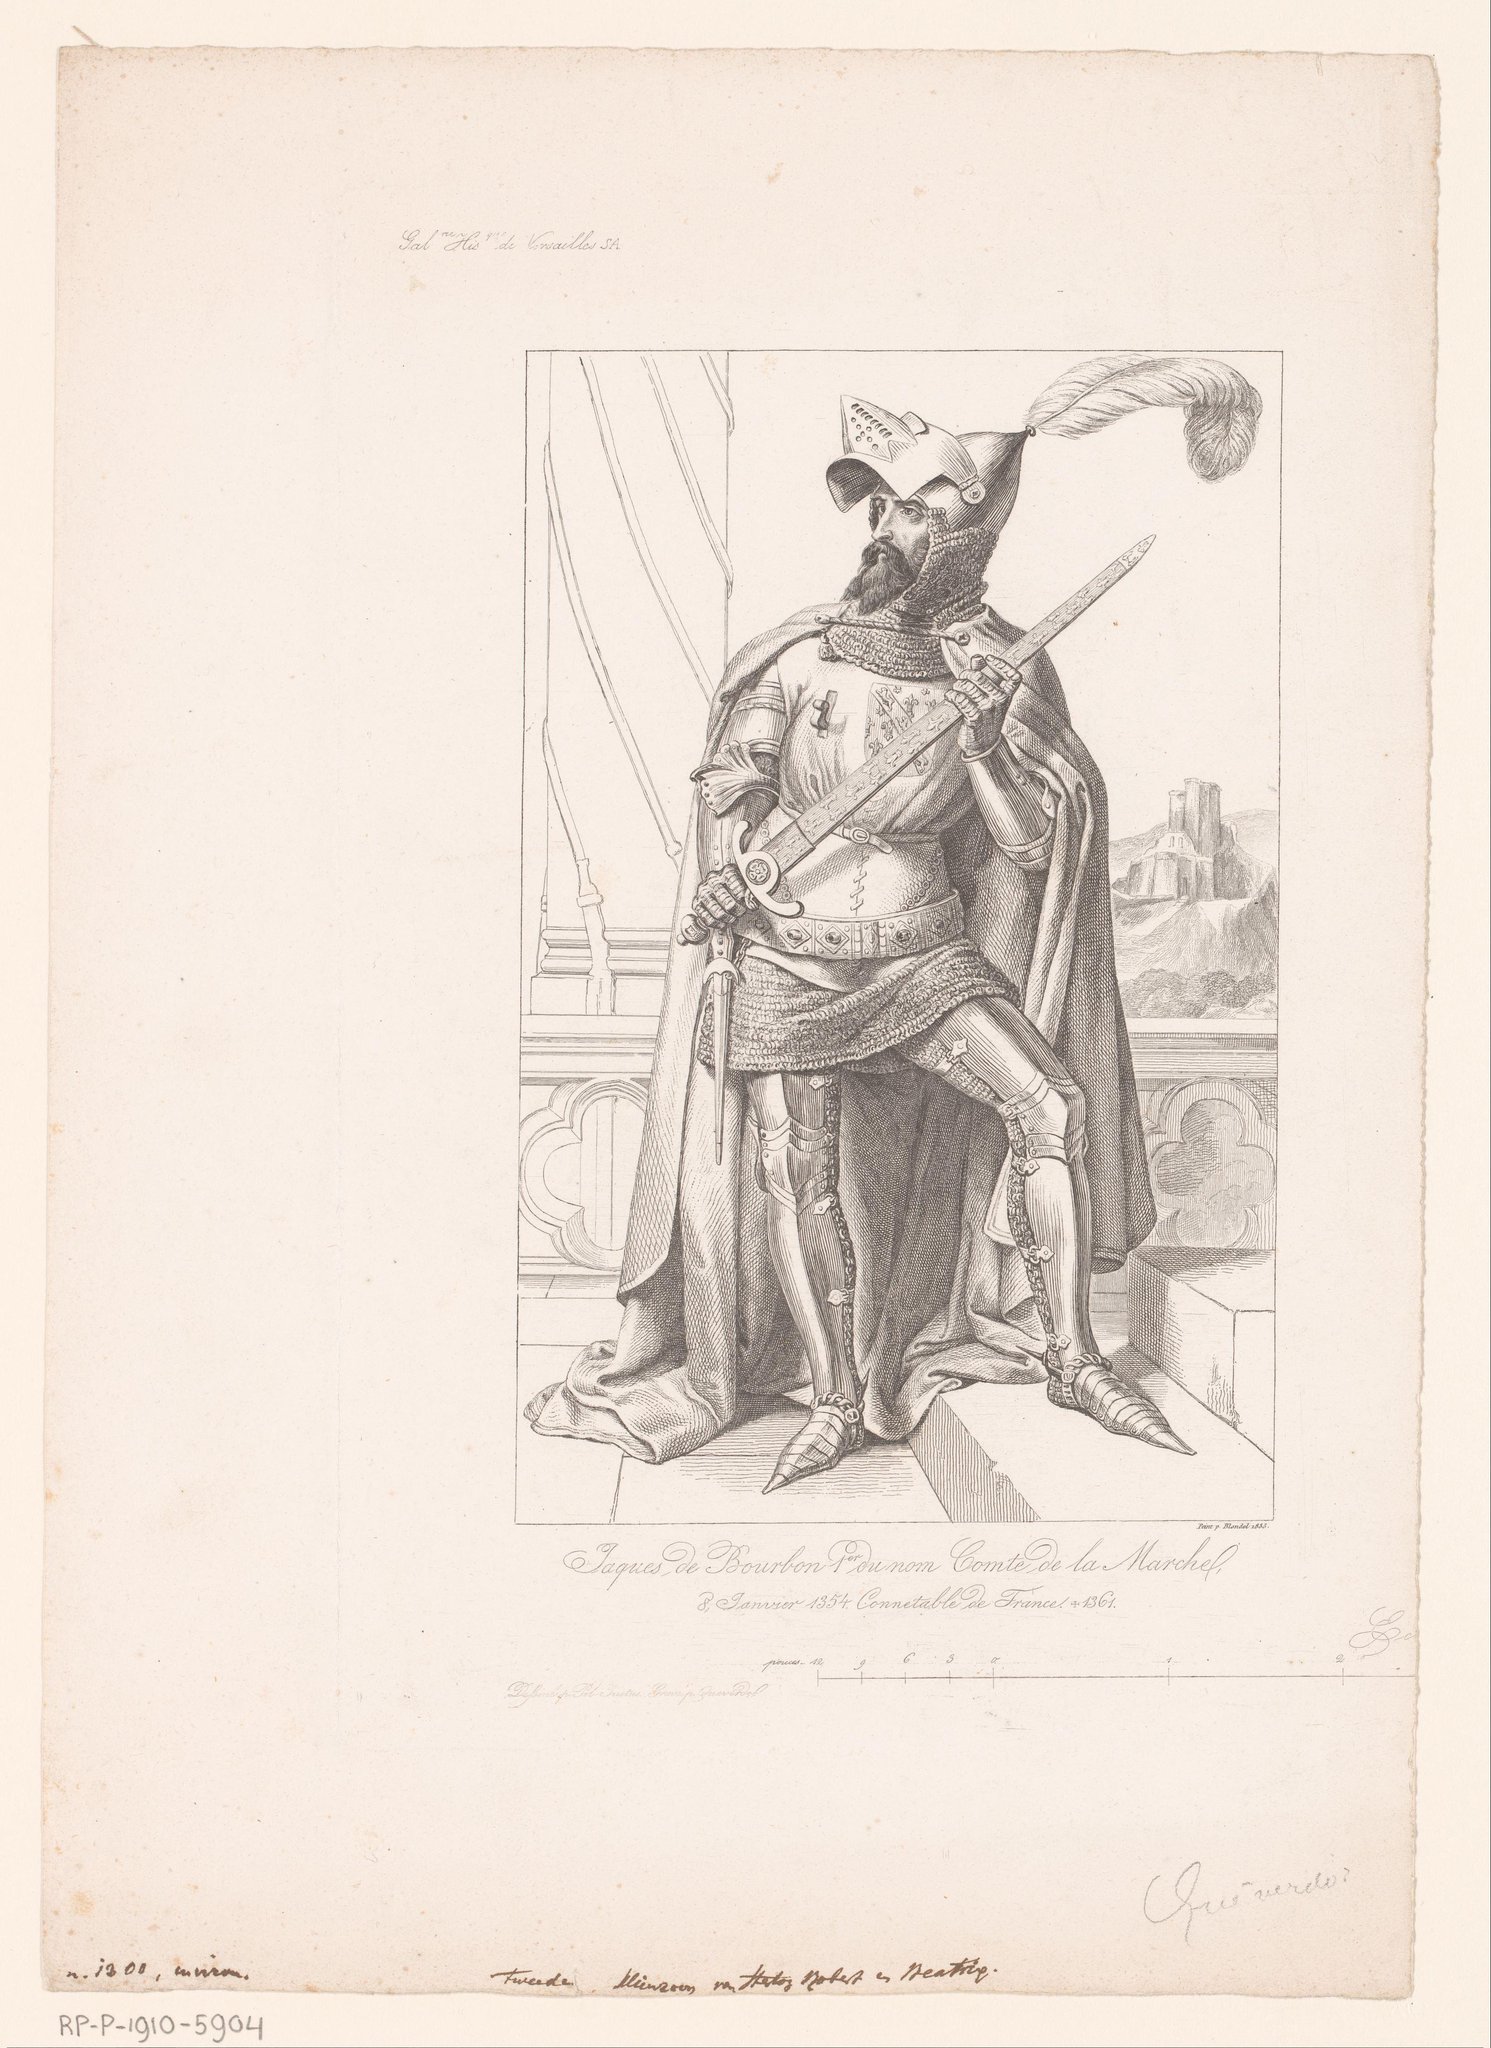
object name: book illustration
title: Portret van Friederich Arnaud hertog van Schomberg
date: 1838-1841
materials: paper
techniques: etching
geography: paris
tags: historical persons, nobility and patriciate; chivalry, knighthood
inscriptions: collector's mark: Lugt 2228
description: Prent uit: Galeries historiques de Versailles. Parijs: Charles Gavard, 1838-1841.